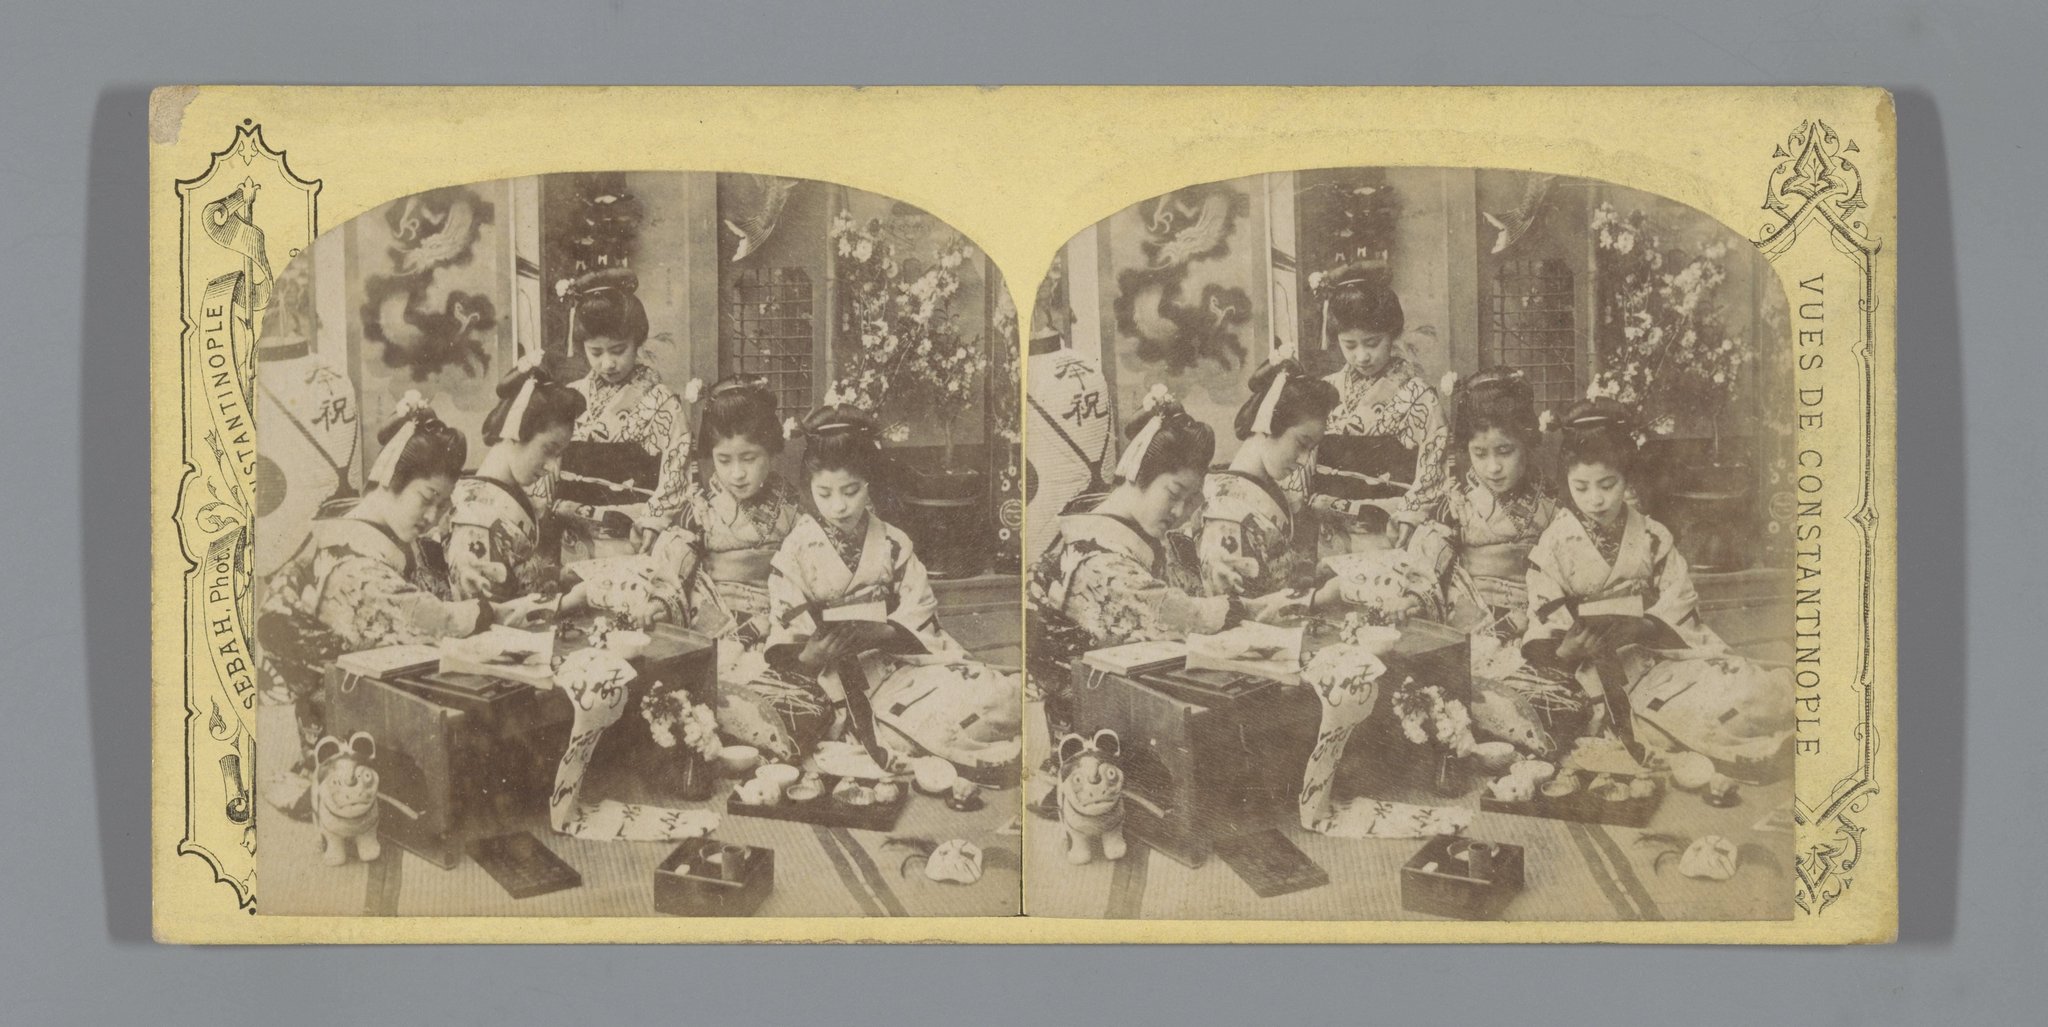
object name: stereograph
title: Japans interieur met vijf Japanse meisjes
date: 1888-1900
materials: cardboard, photographic support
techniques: albumen print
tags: drawing, japanese, tea-ceremony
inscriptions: : ‘Vues de Constantinople’